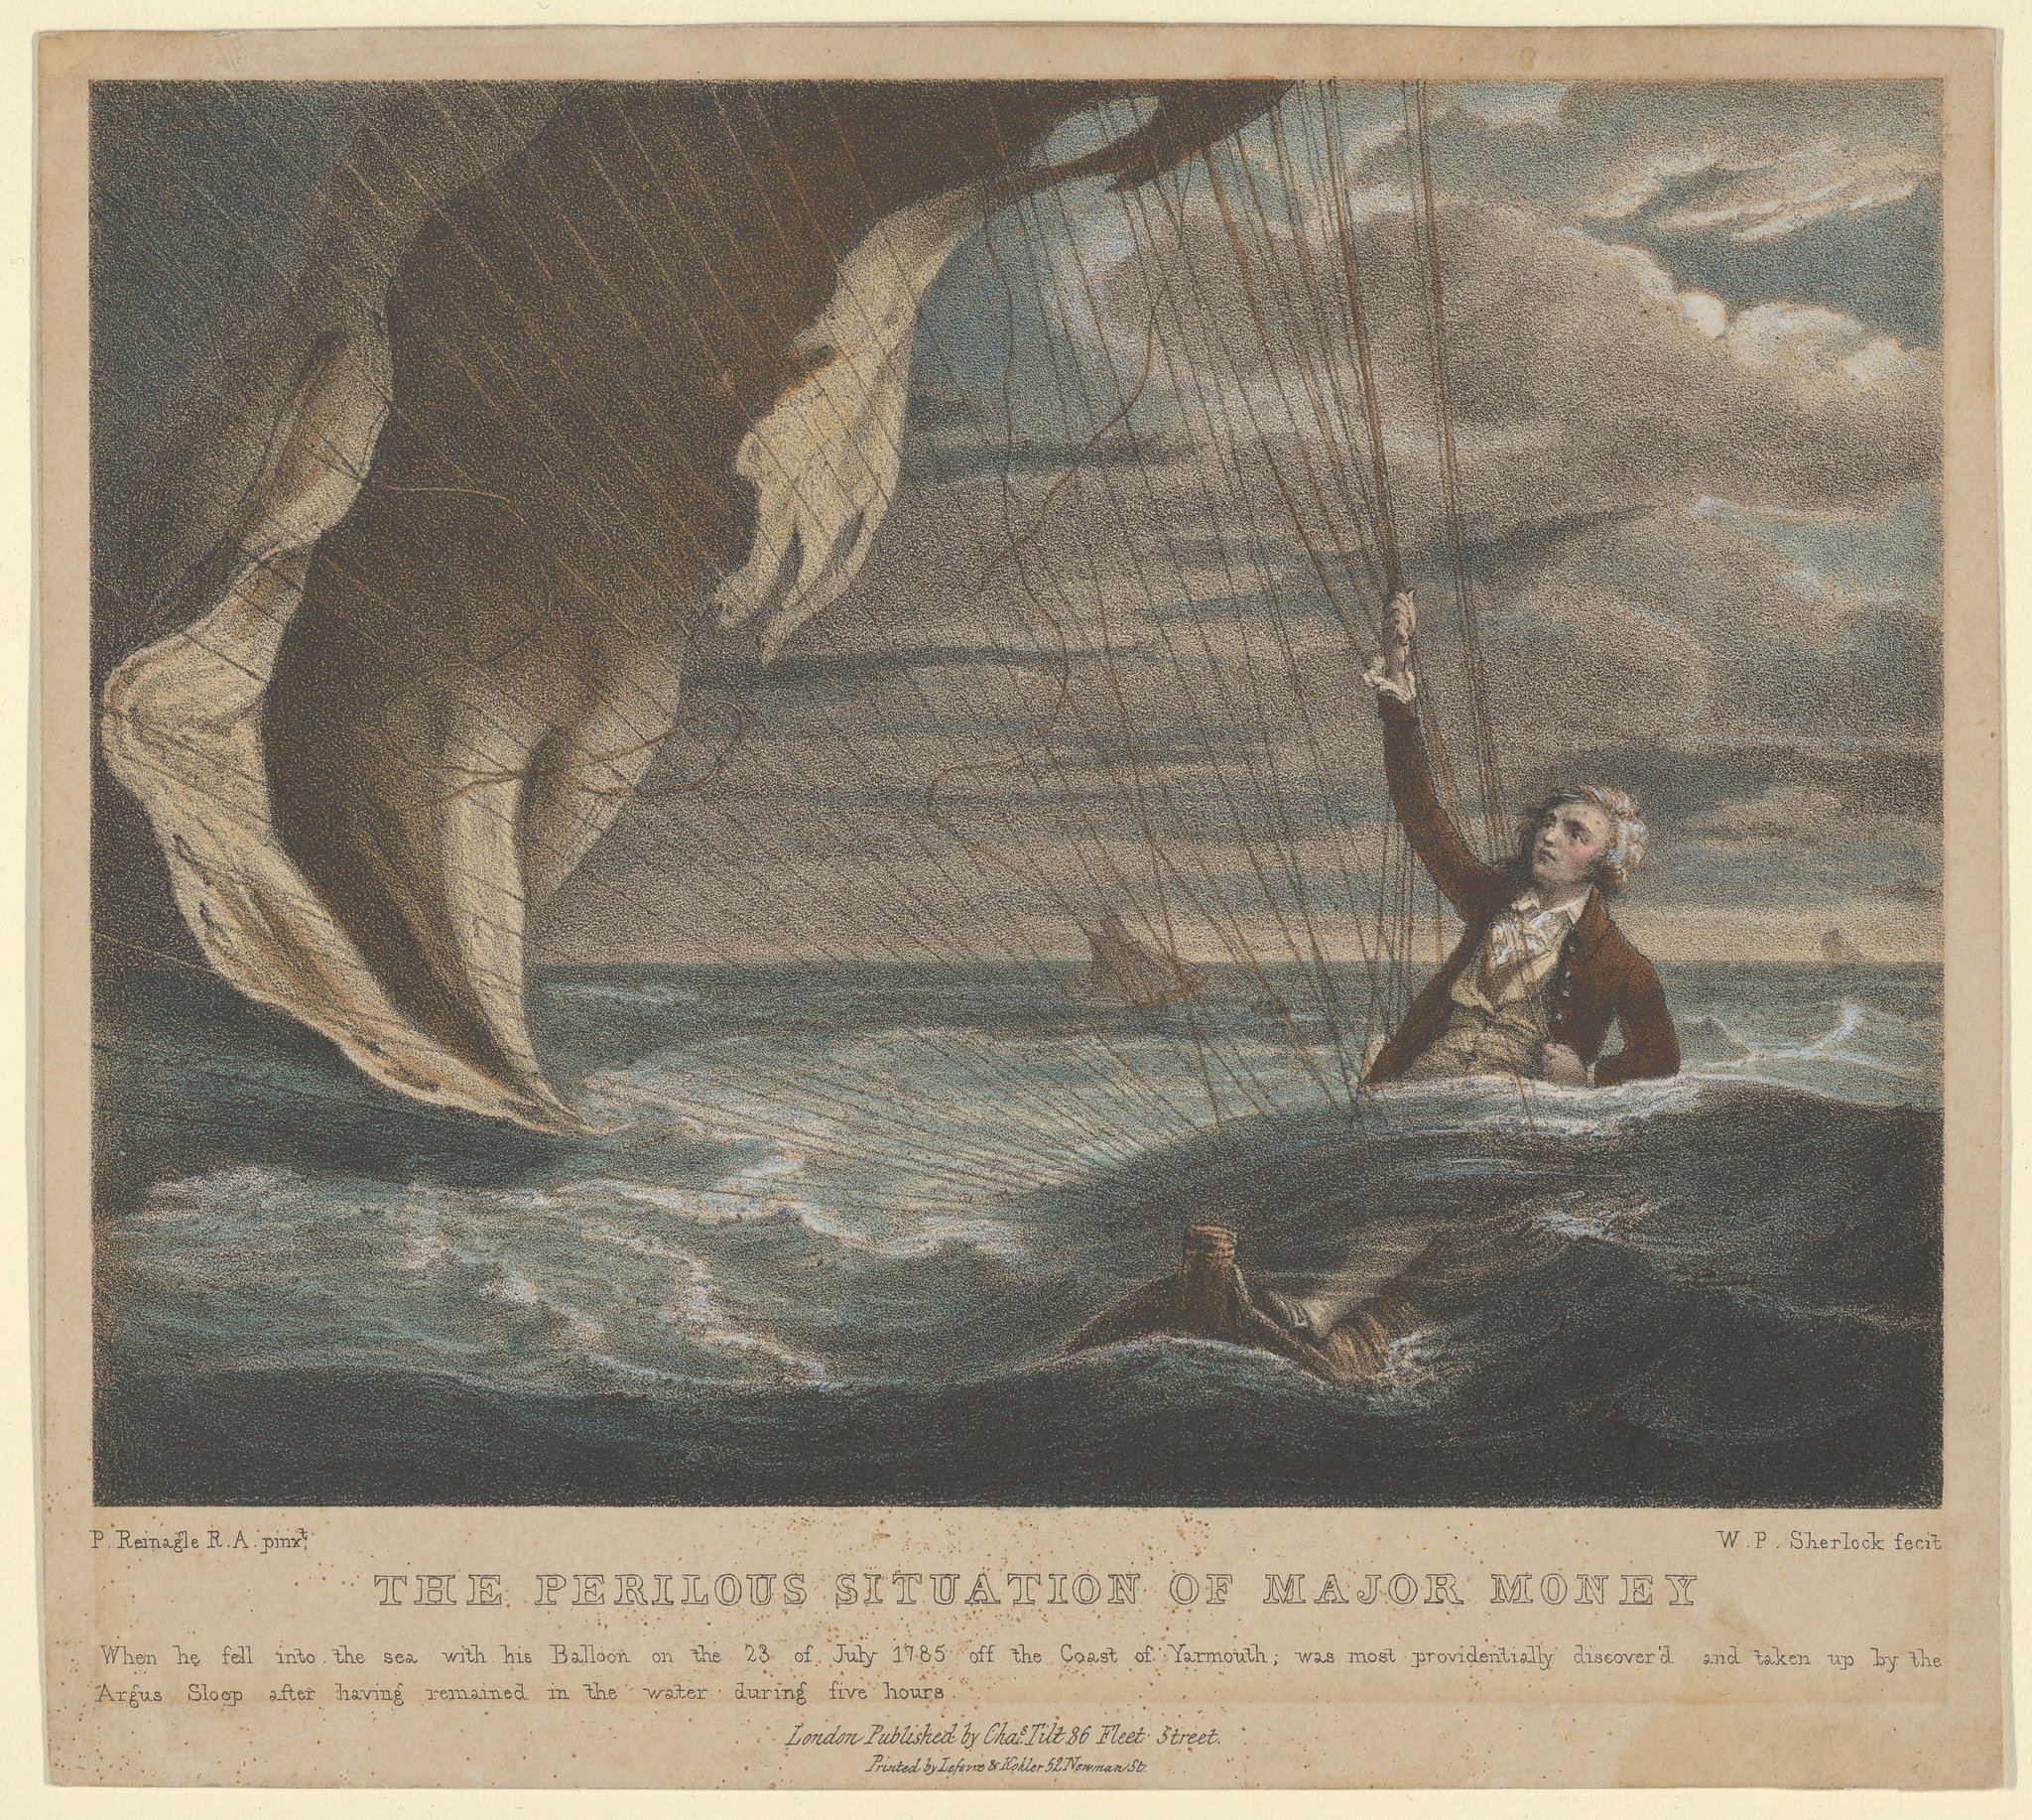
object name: print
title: Major Money Adrift in the North Sea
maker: william p. sherlock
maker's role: artist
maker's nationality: british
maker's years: 1770-1821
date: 1801-1833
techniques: hand coloring, lithograph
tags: men,balloons